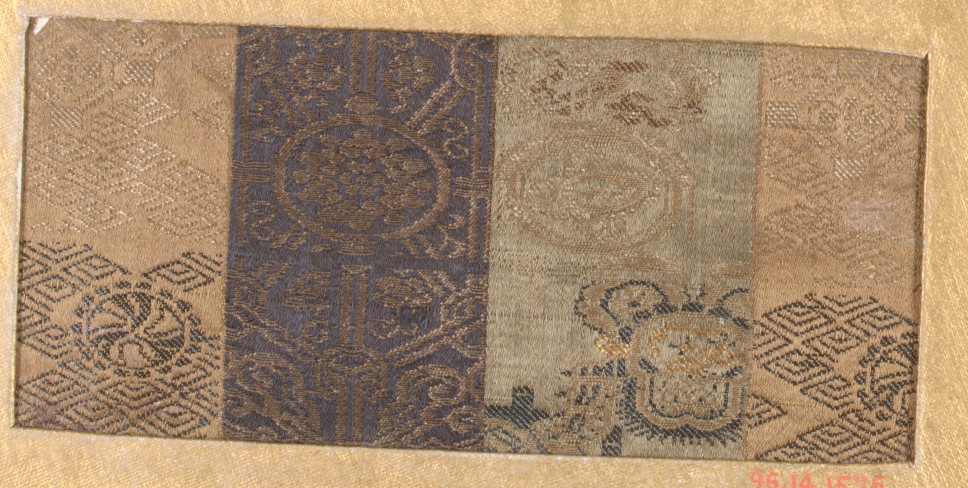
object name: piece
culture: japanese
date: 1701-1900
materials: silk